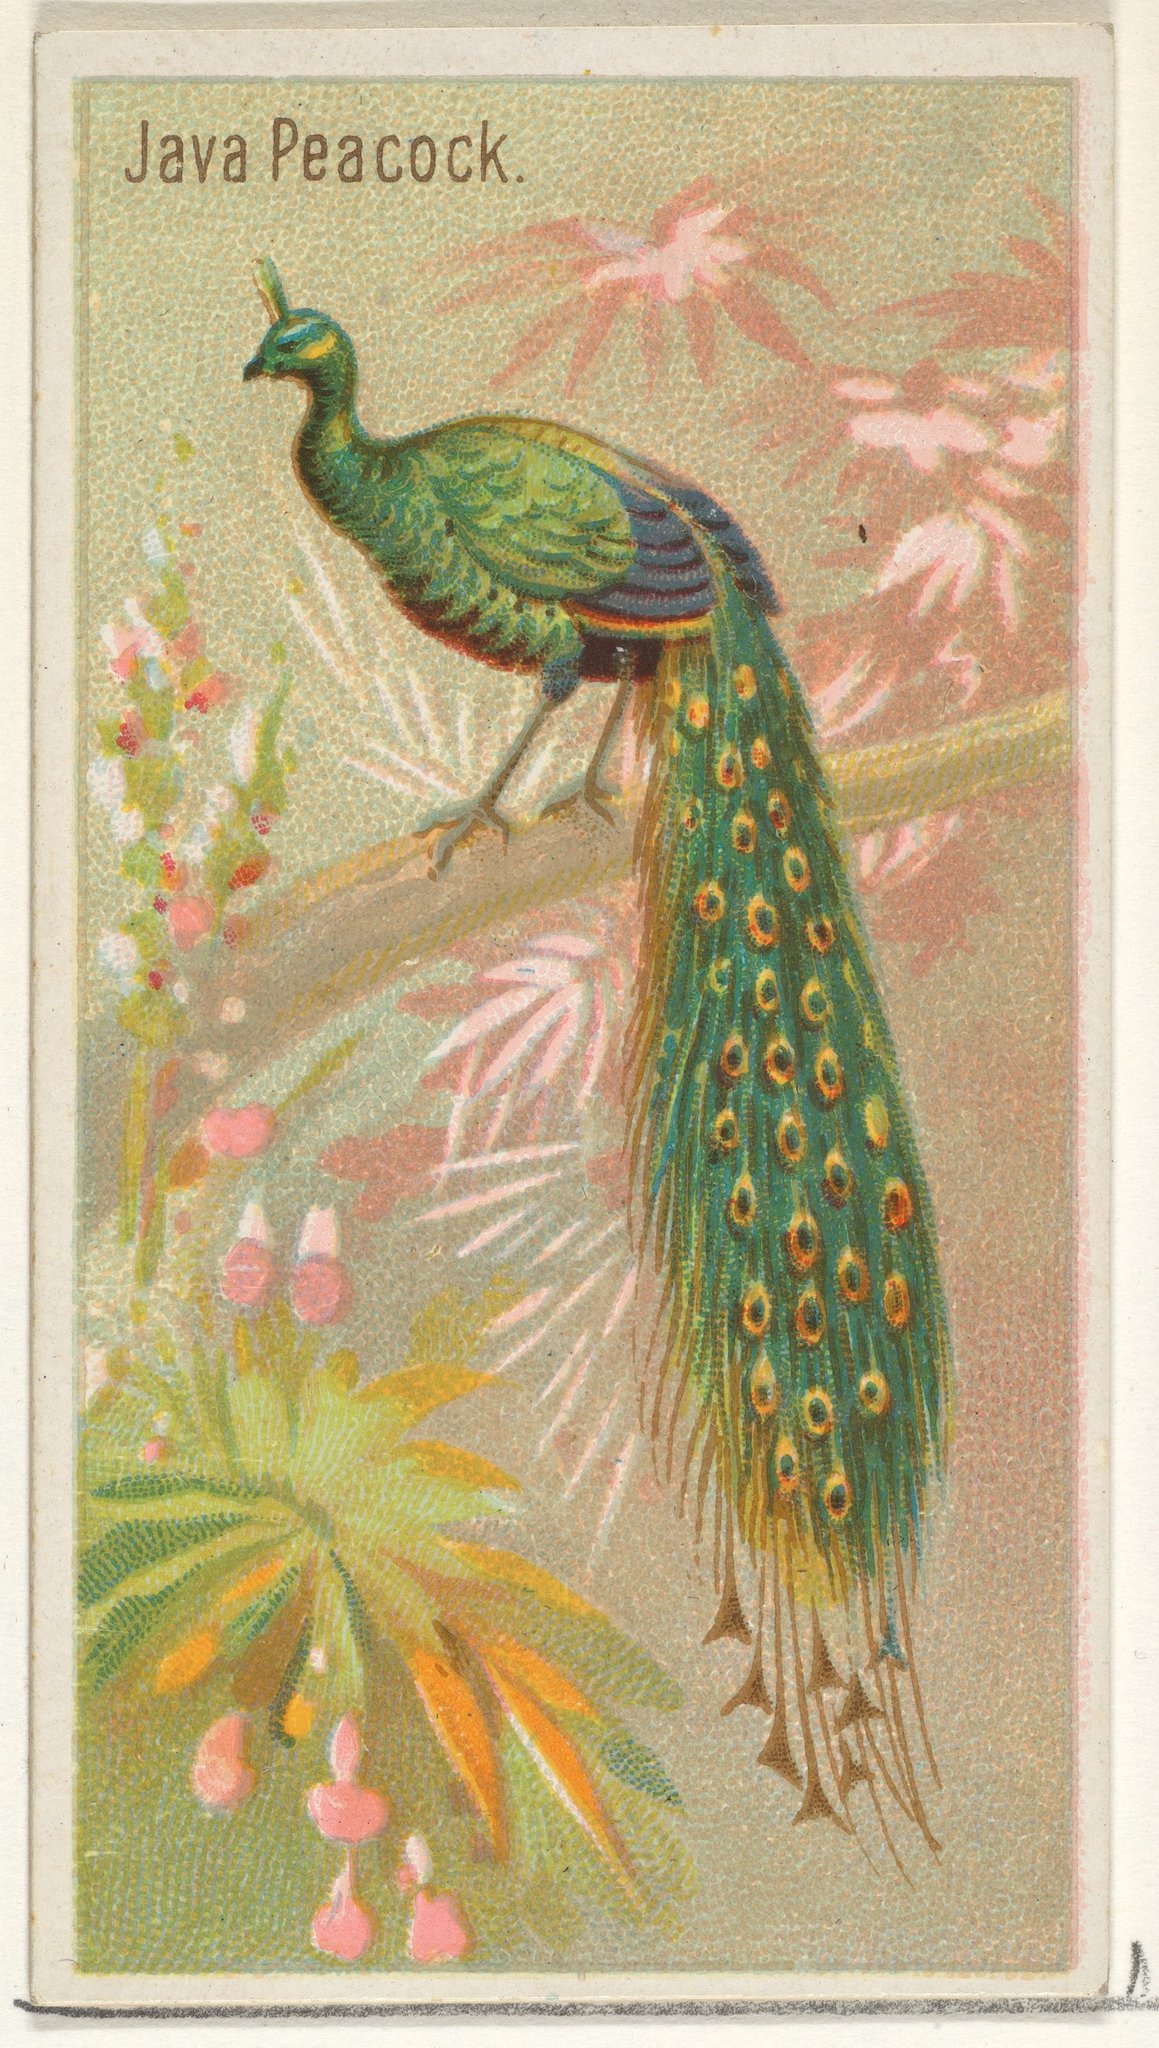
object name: print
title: Java Peacock, from the Birds of the Tropics series (N5) for Allen & Ginter Cigarettes Brands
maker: allen & ginter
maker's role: publisher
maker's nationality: american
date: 1889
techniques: color lithograph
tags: peacocks